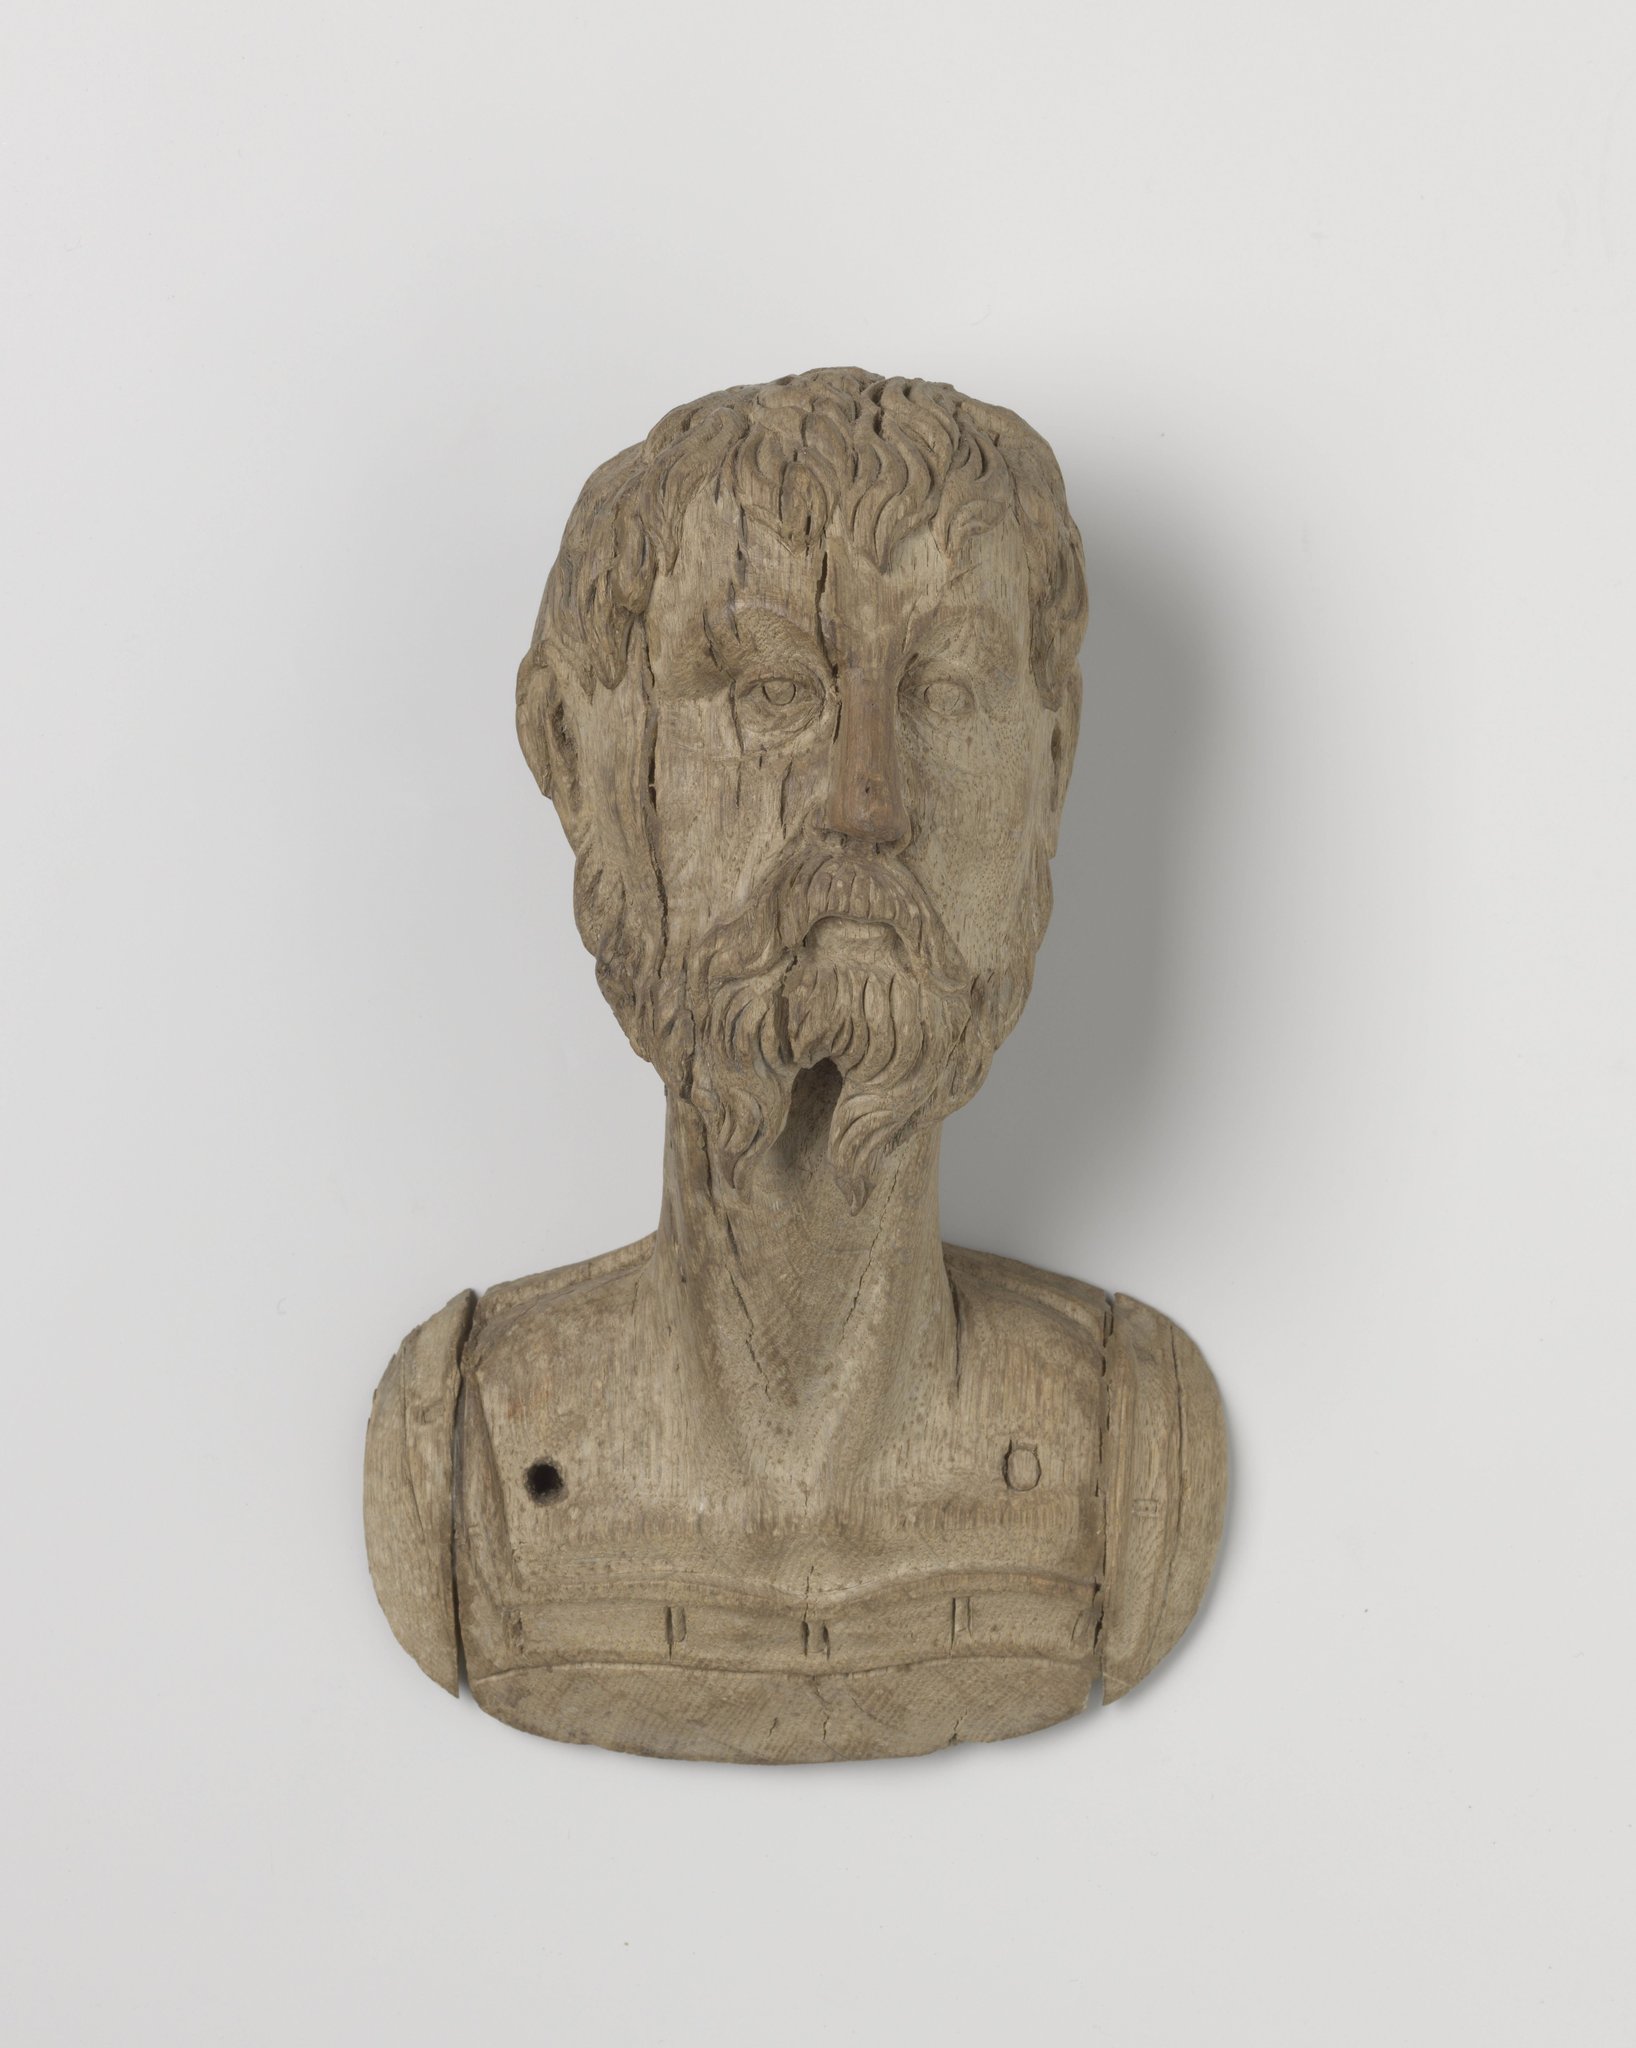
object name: sculpture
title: Langhalzige mannenkop van hout, horend bij het orgel afkomstig uit de Nicolaïkerk in Utrecht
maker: Anonymous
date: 1477-1481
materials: wood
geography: northern netherlands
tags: nicolaïkerk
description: Langhalzige mannenkop van hout, horend bij het orgel afkomstig uit de Nicolaïkerk in Utrecht.